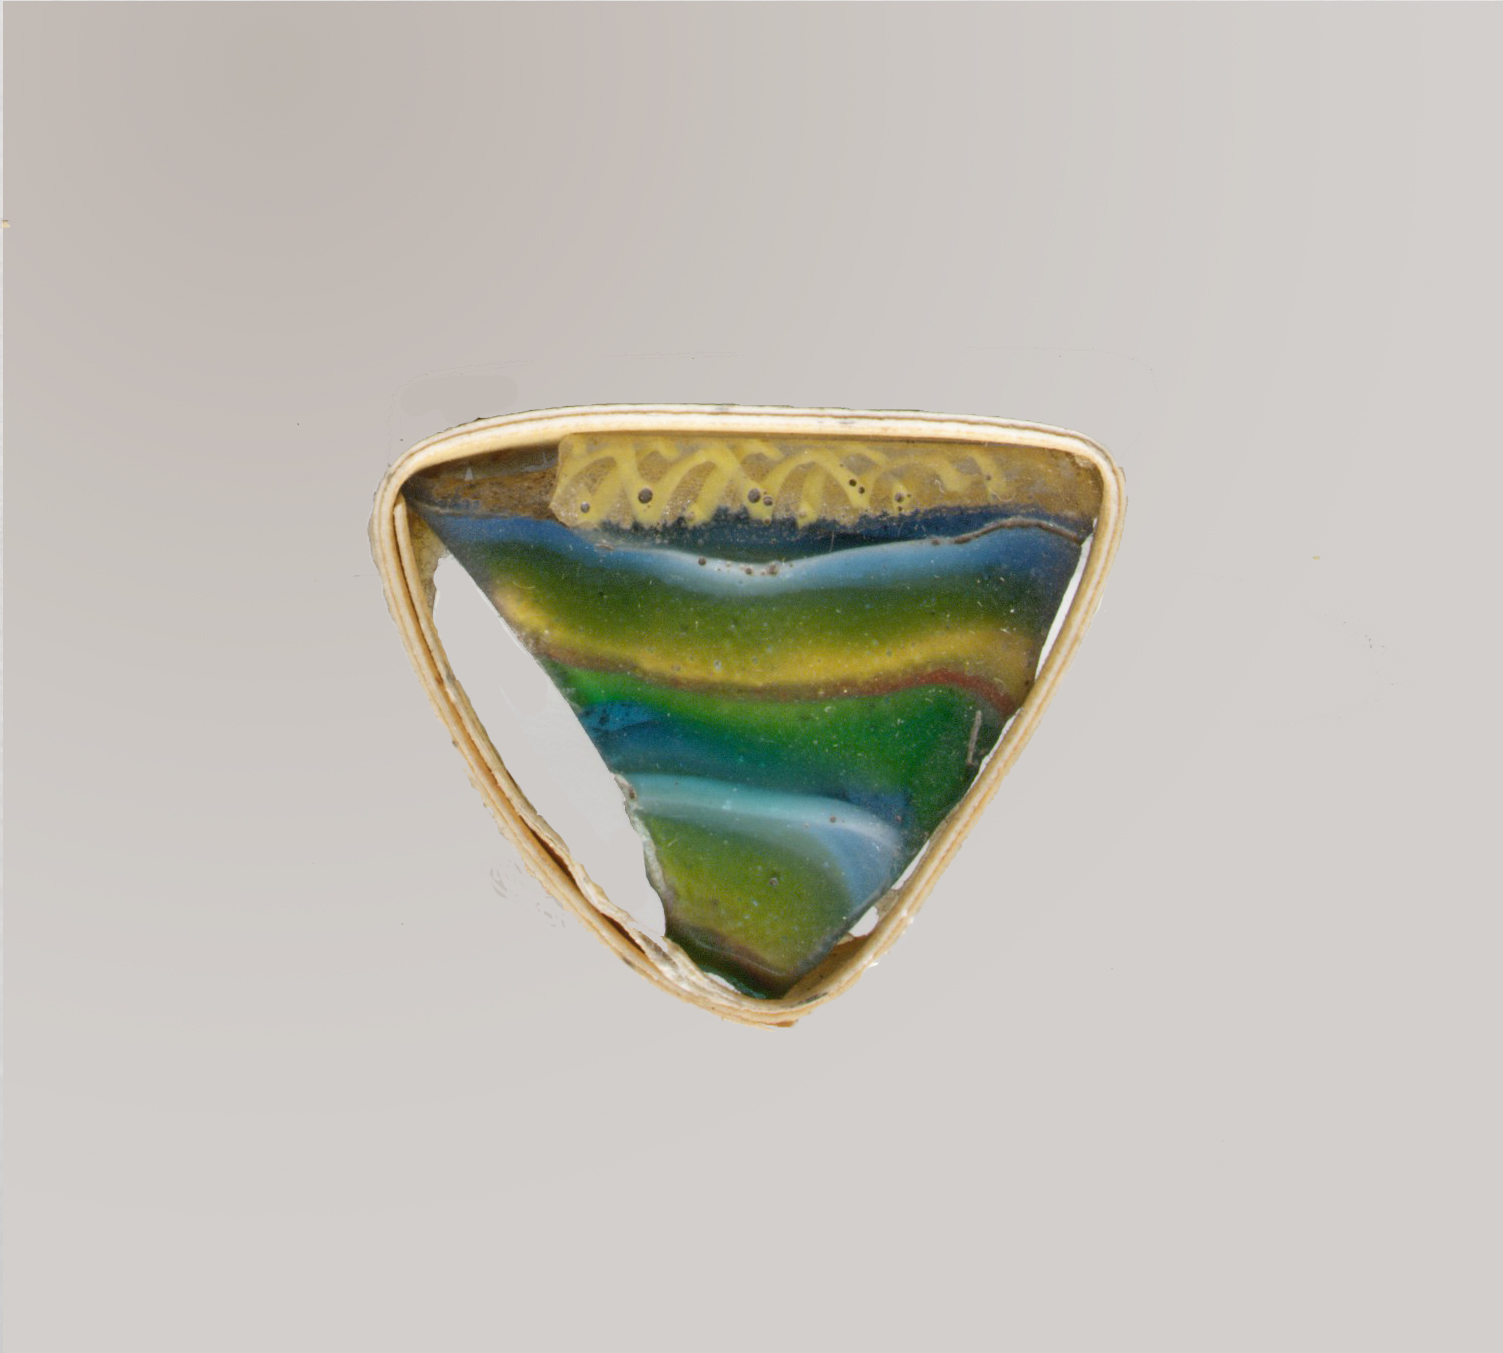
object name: fragment, mosaic bowl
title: Glass striped mosaic bowl fragment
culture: roman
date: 34 BCE-33 CE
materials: glass